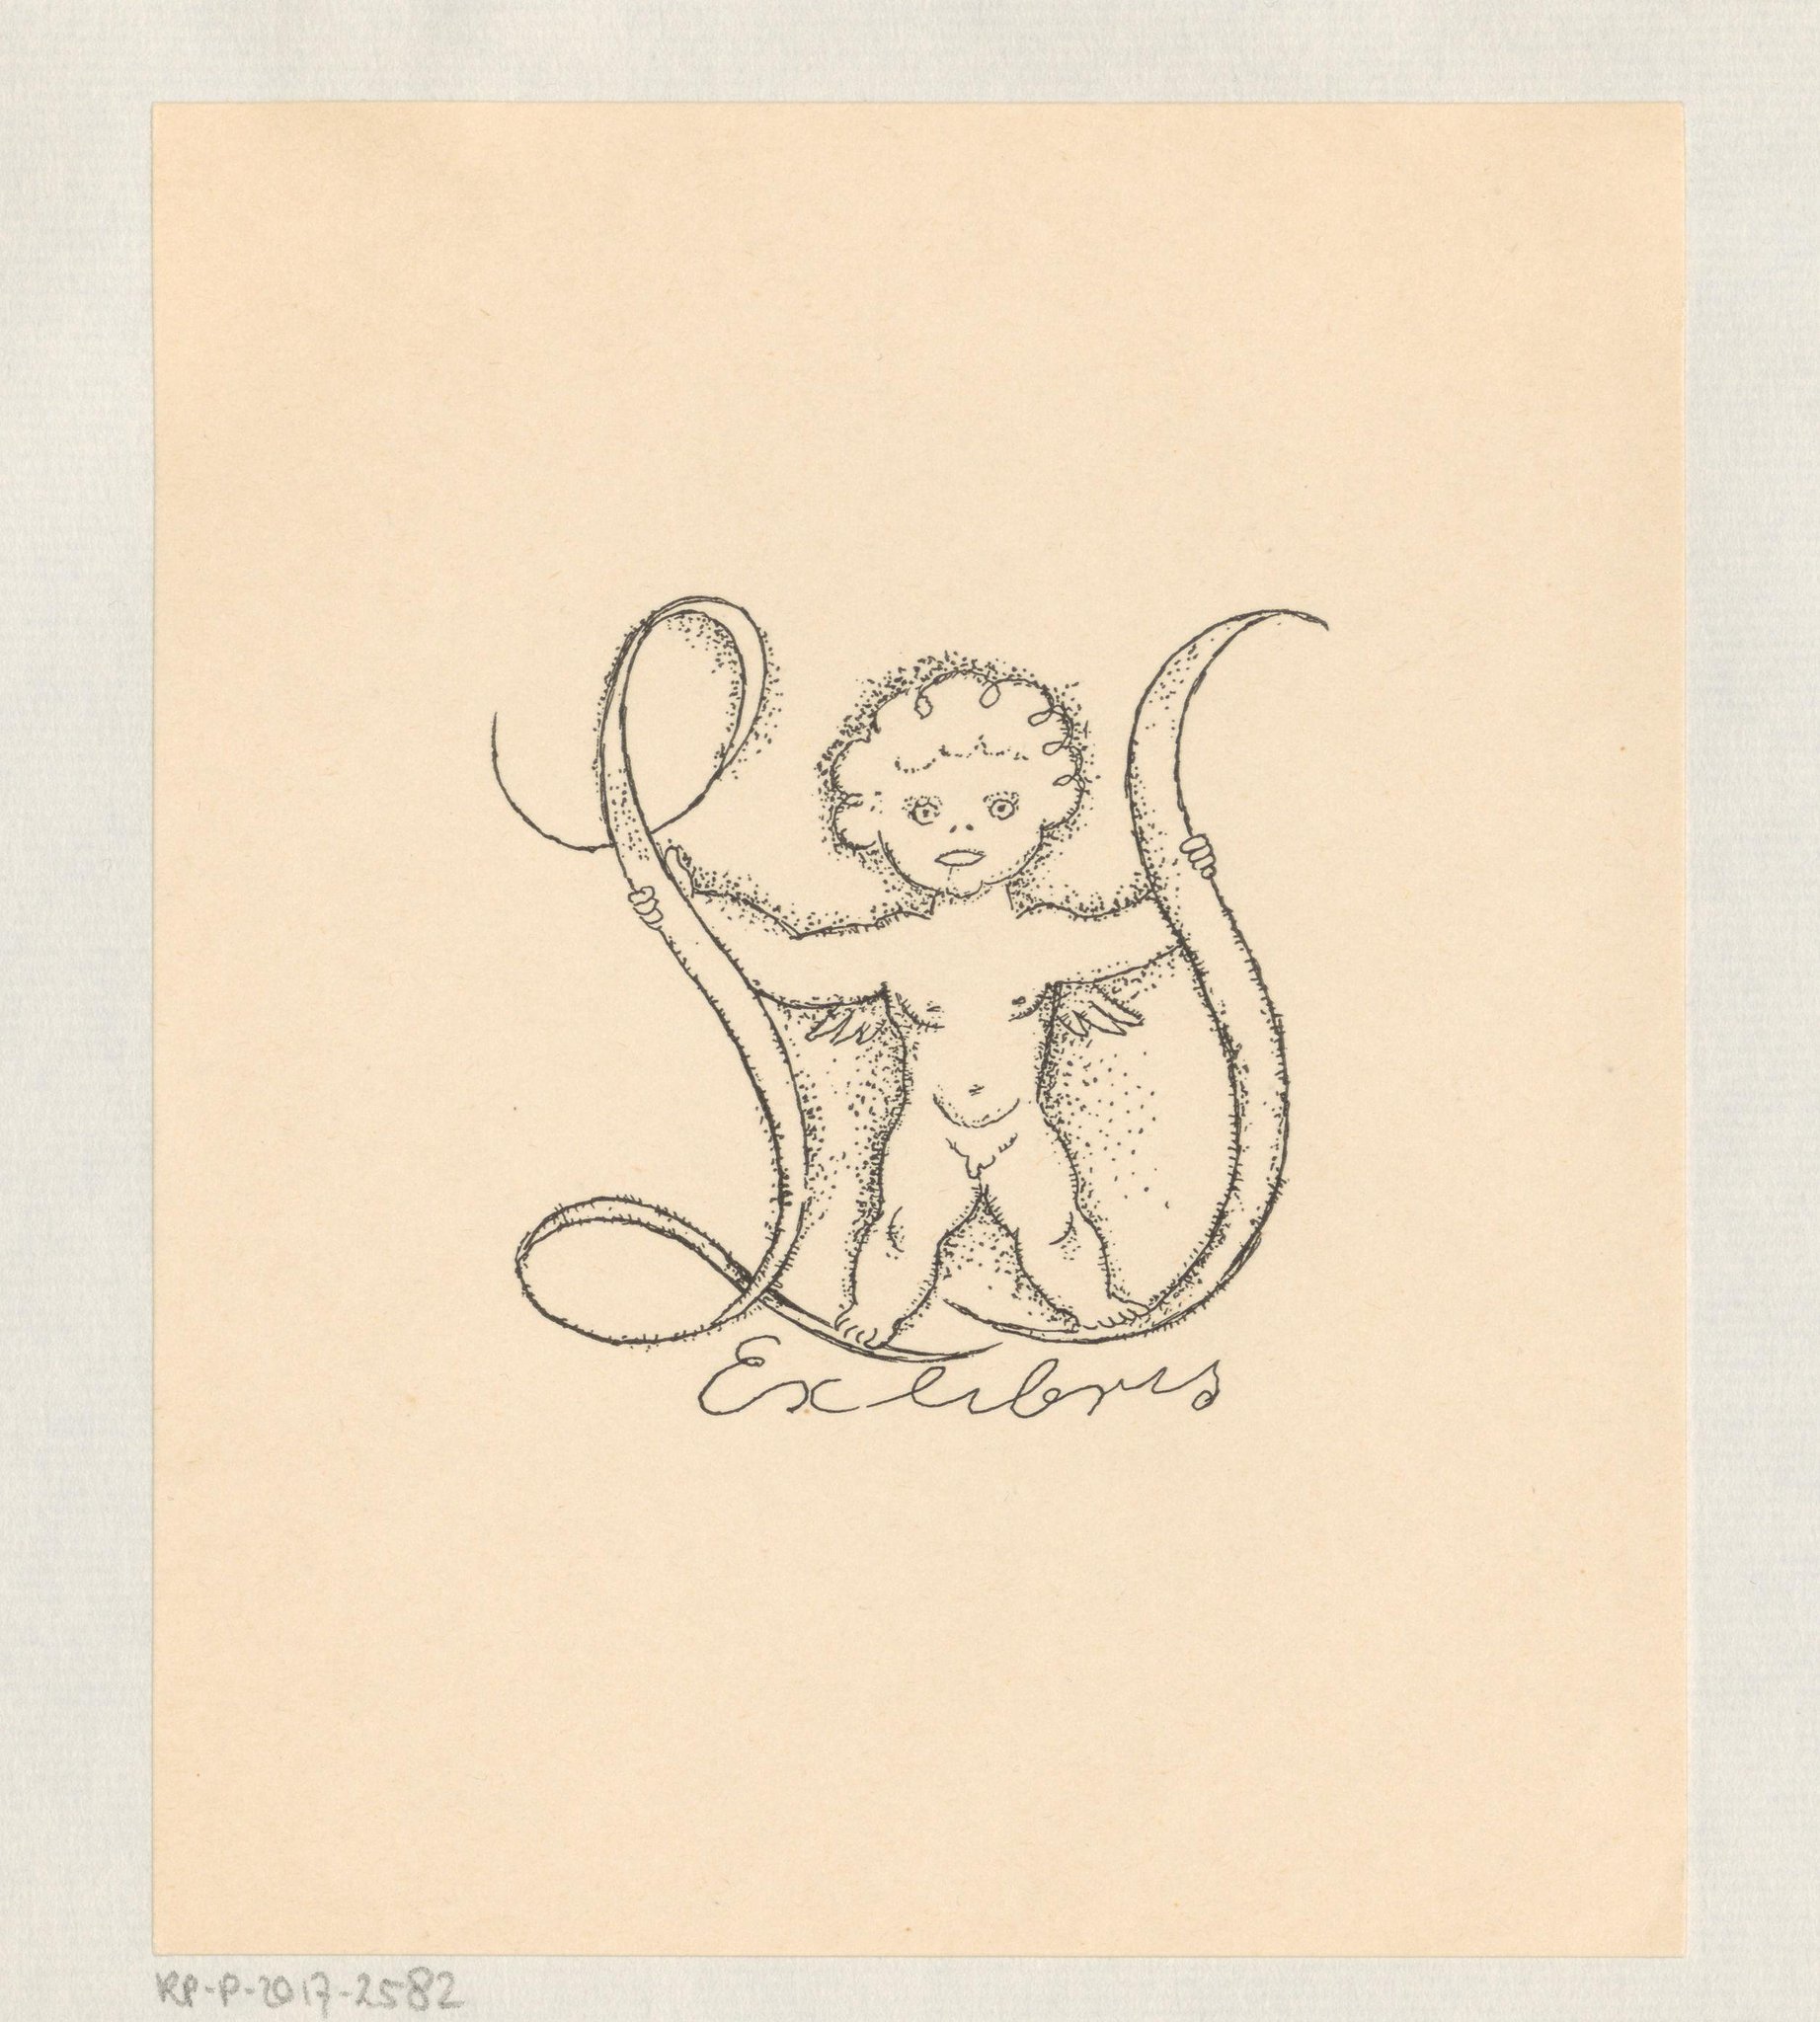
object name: bookplate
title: Ex libris van L.S.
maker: michel fingesten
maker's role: painter, print maker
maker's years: 1884-1943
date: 1894-1943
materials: paper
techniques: lithograph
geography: milan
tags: cupids: 'amores', 'amoretti', 'putti'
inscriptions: workshop stamp: ‘Michel Fingesten / Milano’